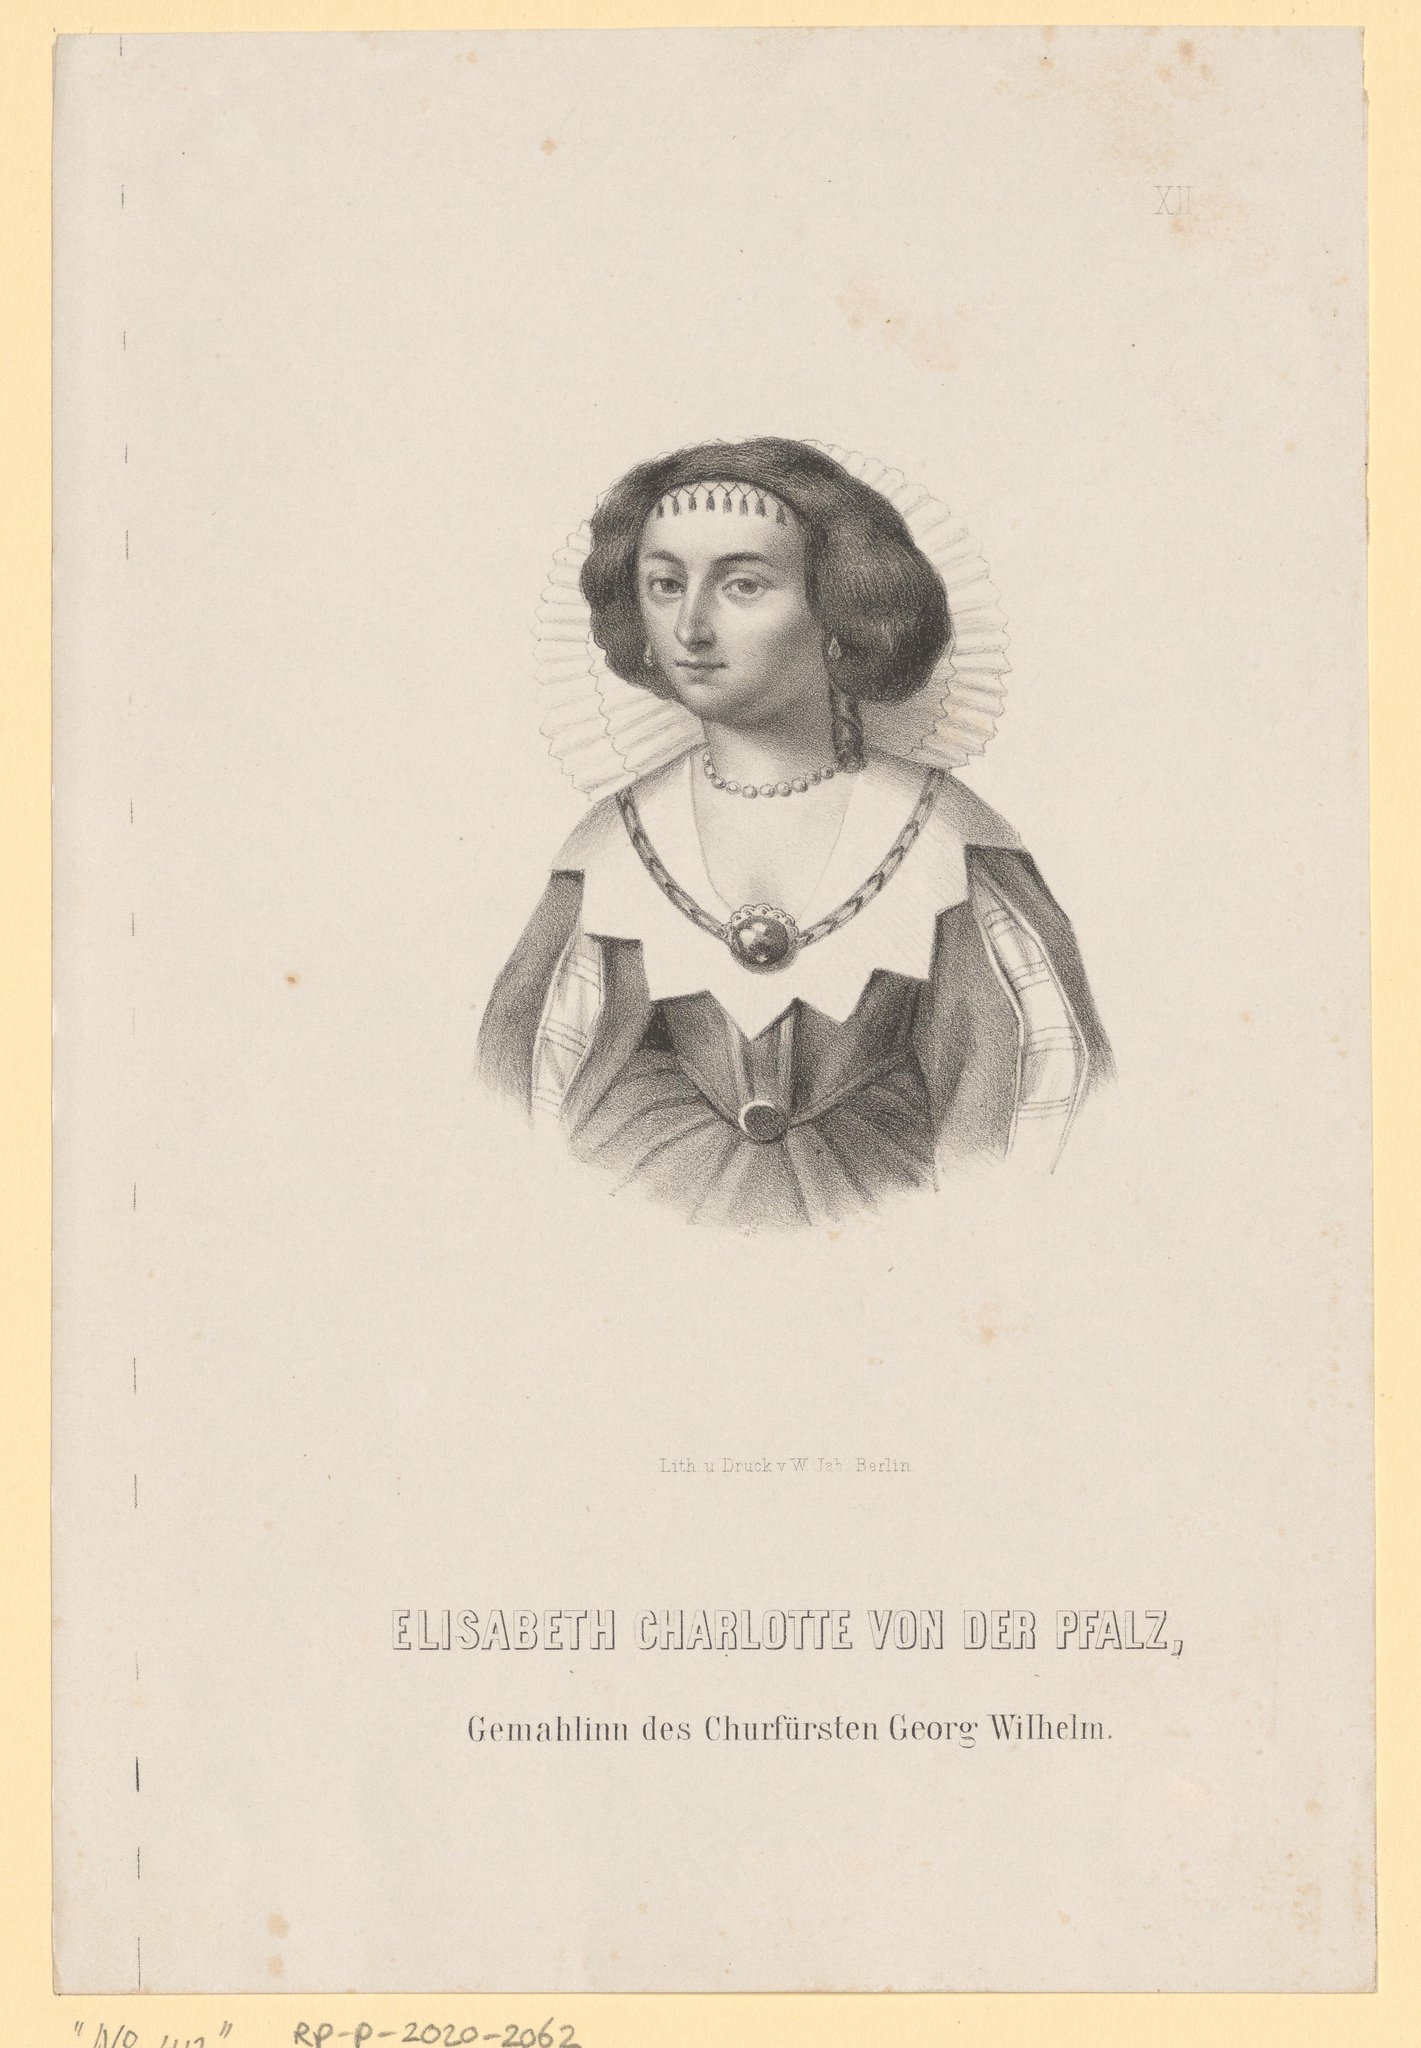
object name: book illustration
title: Portret van Elisabeth Charlotte van de Palts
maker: wilhelm jab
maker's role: print maker, printer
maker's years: -1871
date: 1867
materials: paper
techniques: lithograph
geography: berlin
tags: historical persons - bb - woman, pearl; pearl necklace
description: Prent waarschijnlijk uit: Kirchner, Ernst Daniel Martin. Die Churfürstinnen und Königinnen auf dem Throne der Hohenzollern (...). Berlijn: Wiegandt & Grieben, 1867, dl. 2.